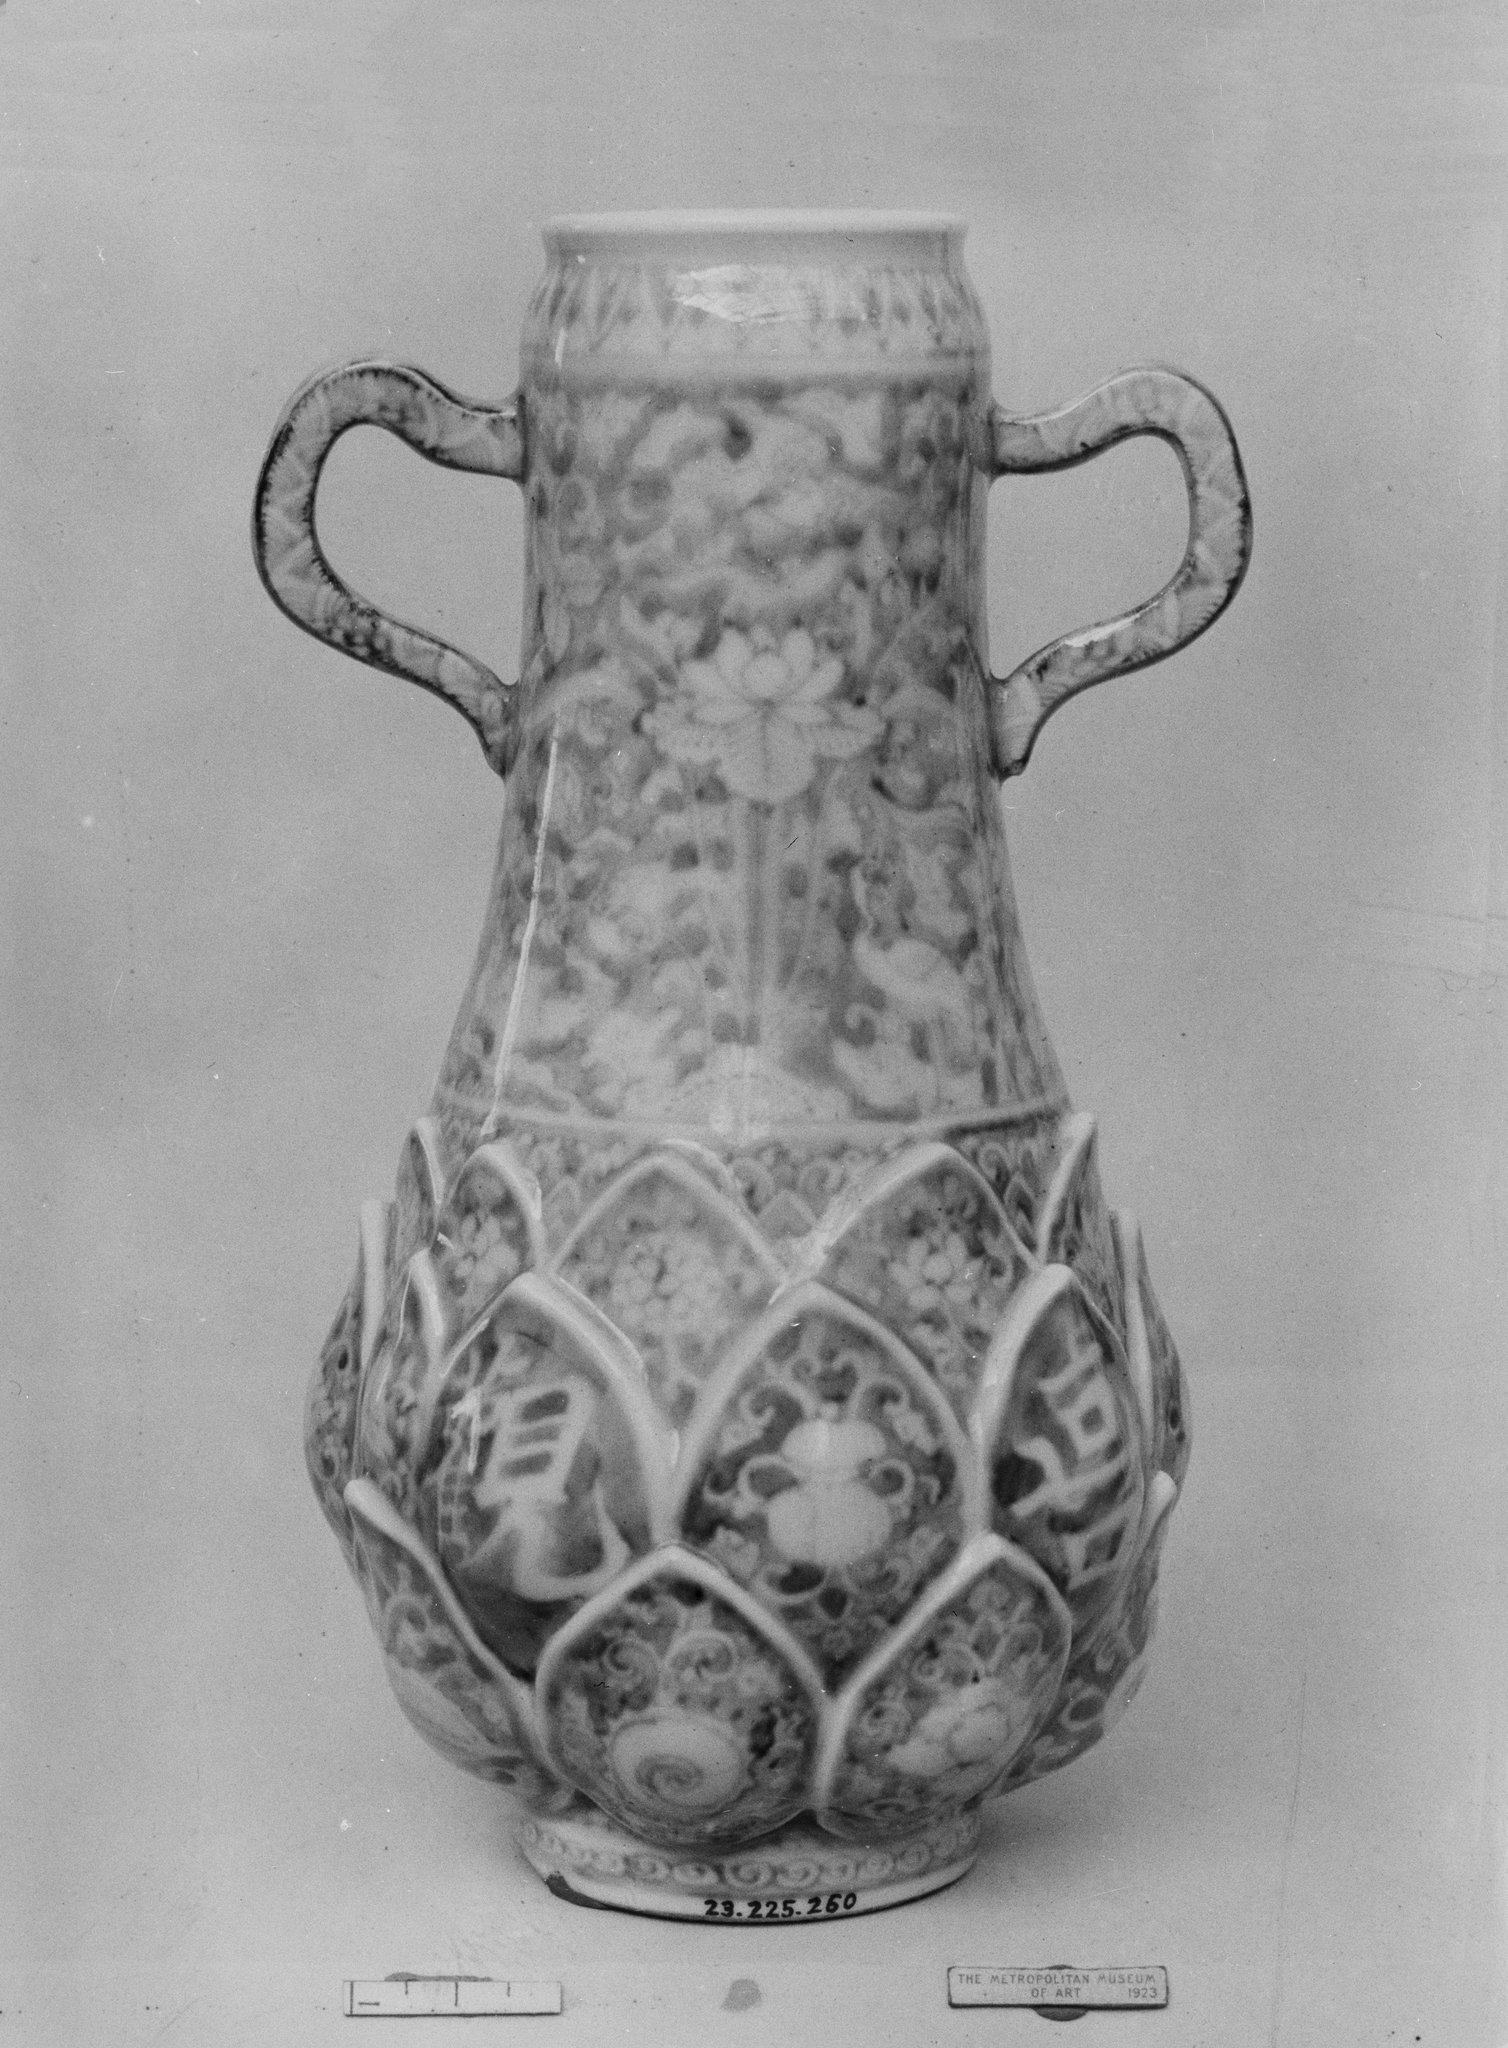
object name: vase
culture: japanese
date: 1800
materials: porcelain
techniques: relief